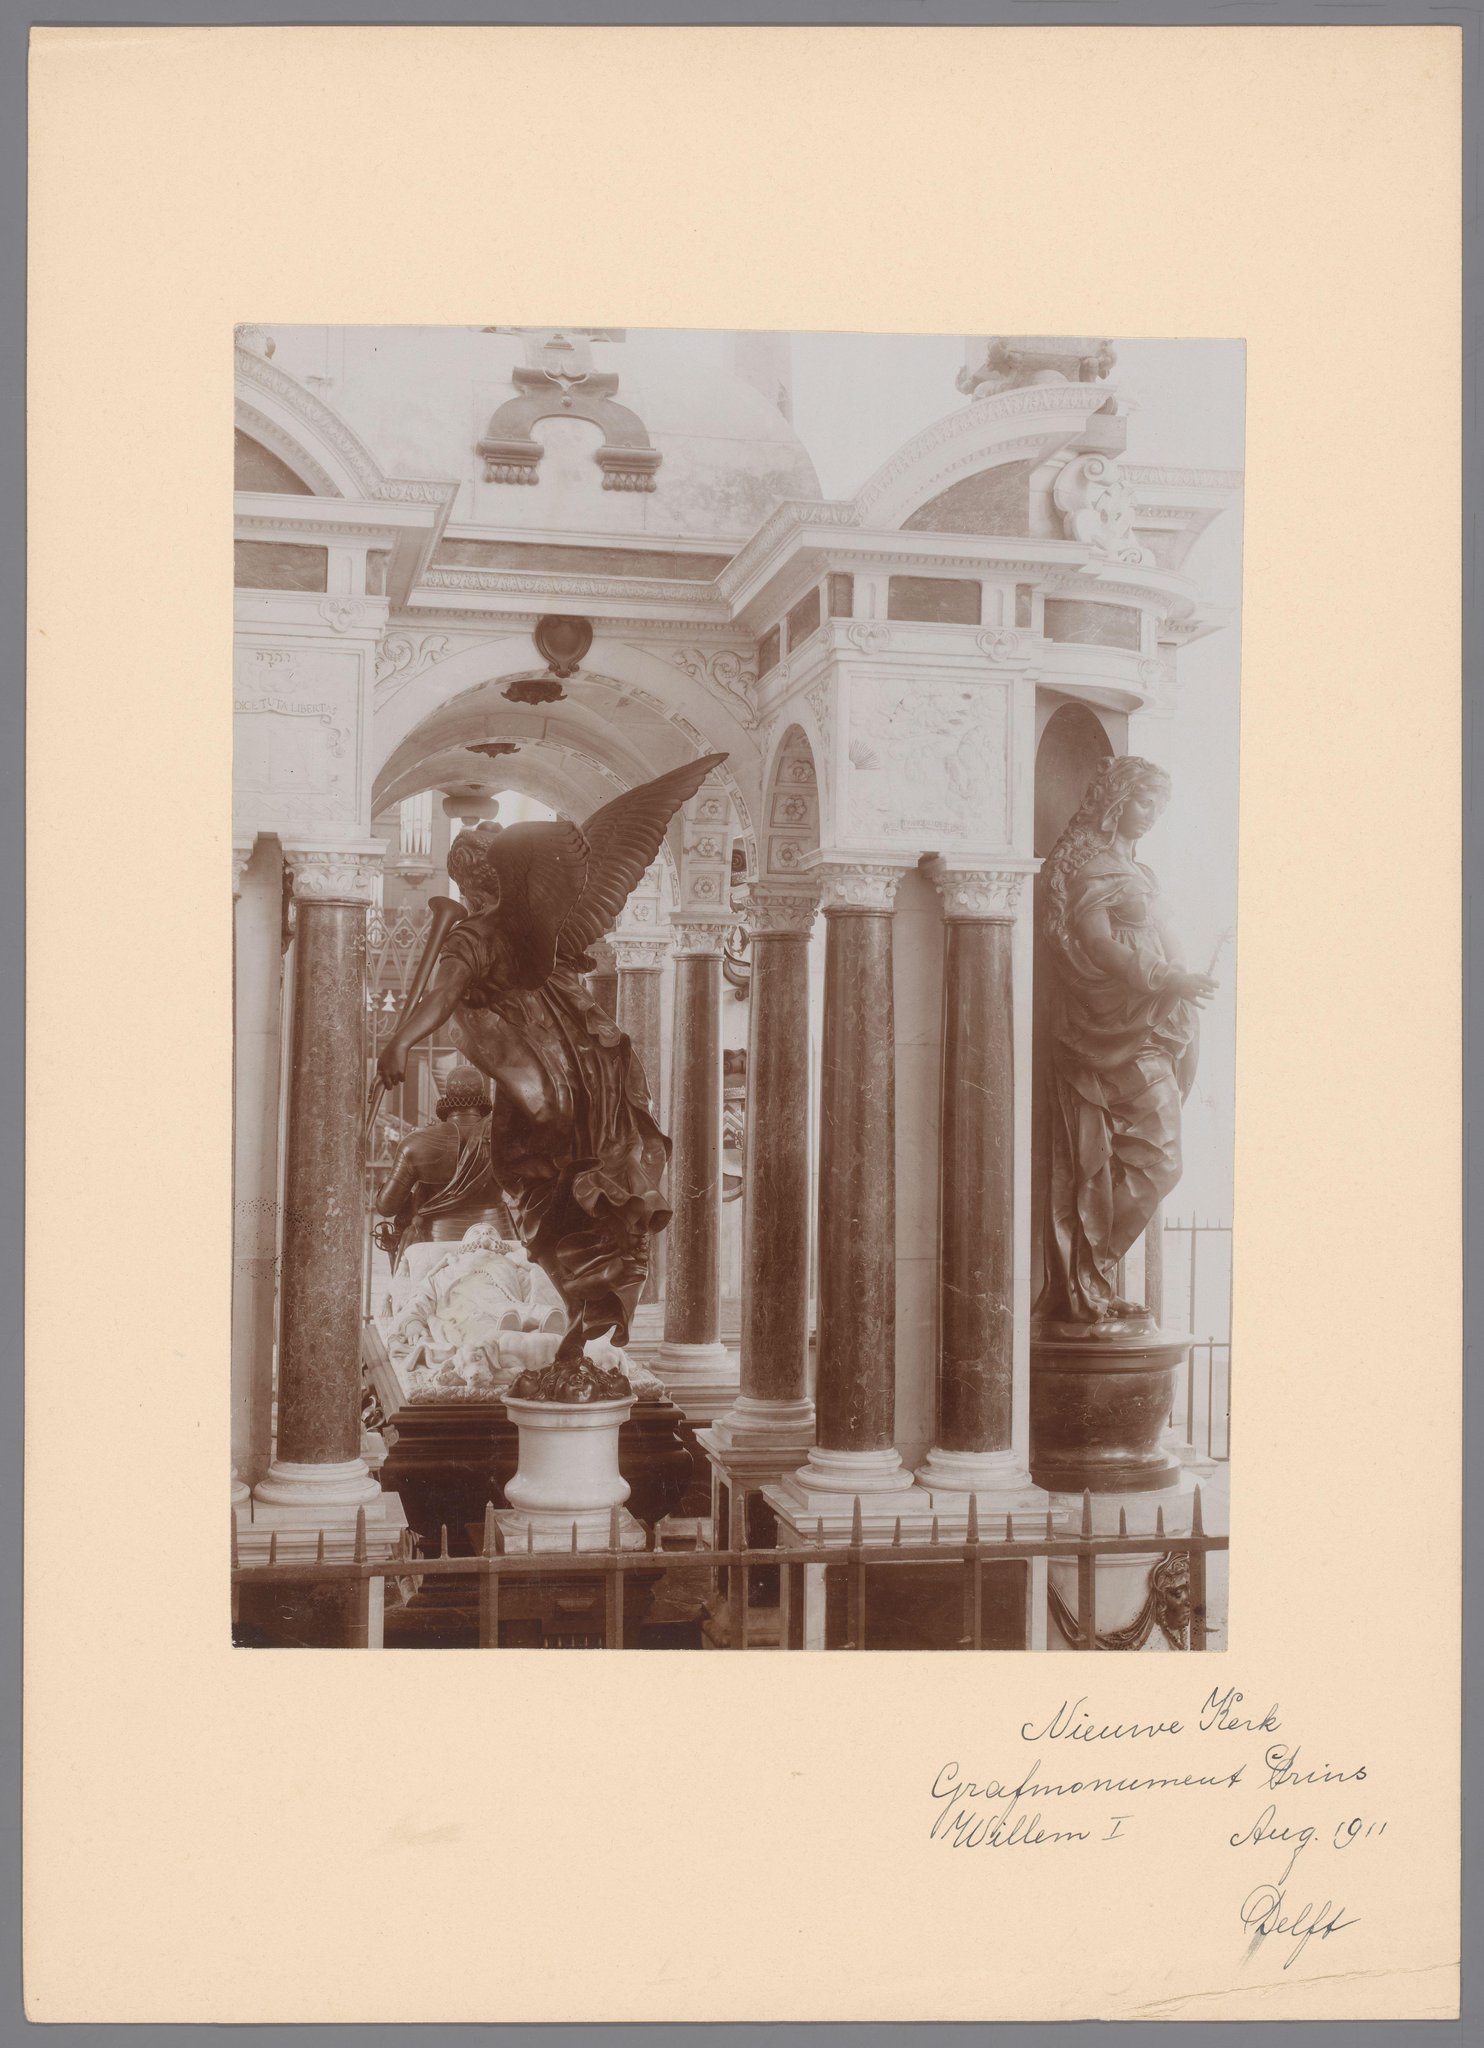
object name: photograph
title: Grafmonument van Willem I Frederik in de Nieuwe Kerk te Delft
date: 1911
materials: cardboard, photographic support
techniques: collodion silver print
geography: nieuwe kerk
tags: the hague, william i of the netherlands, interior of church, grave-building, monumental tomb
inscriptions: annotation: ‘Nieuwe Kerk/ grafmonument prins Willem I/ Aug. 1911/ Delft’